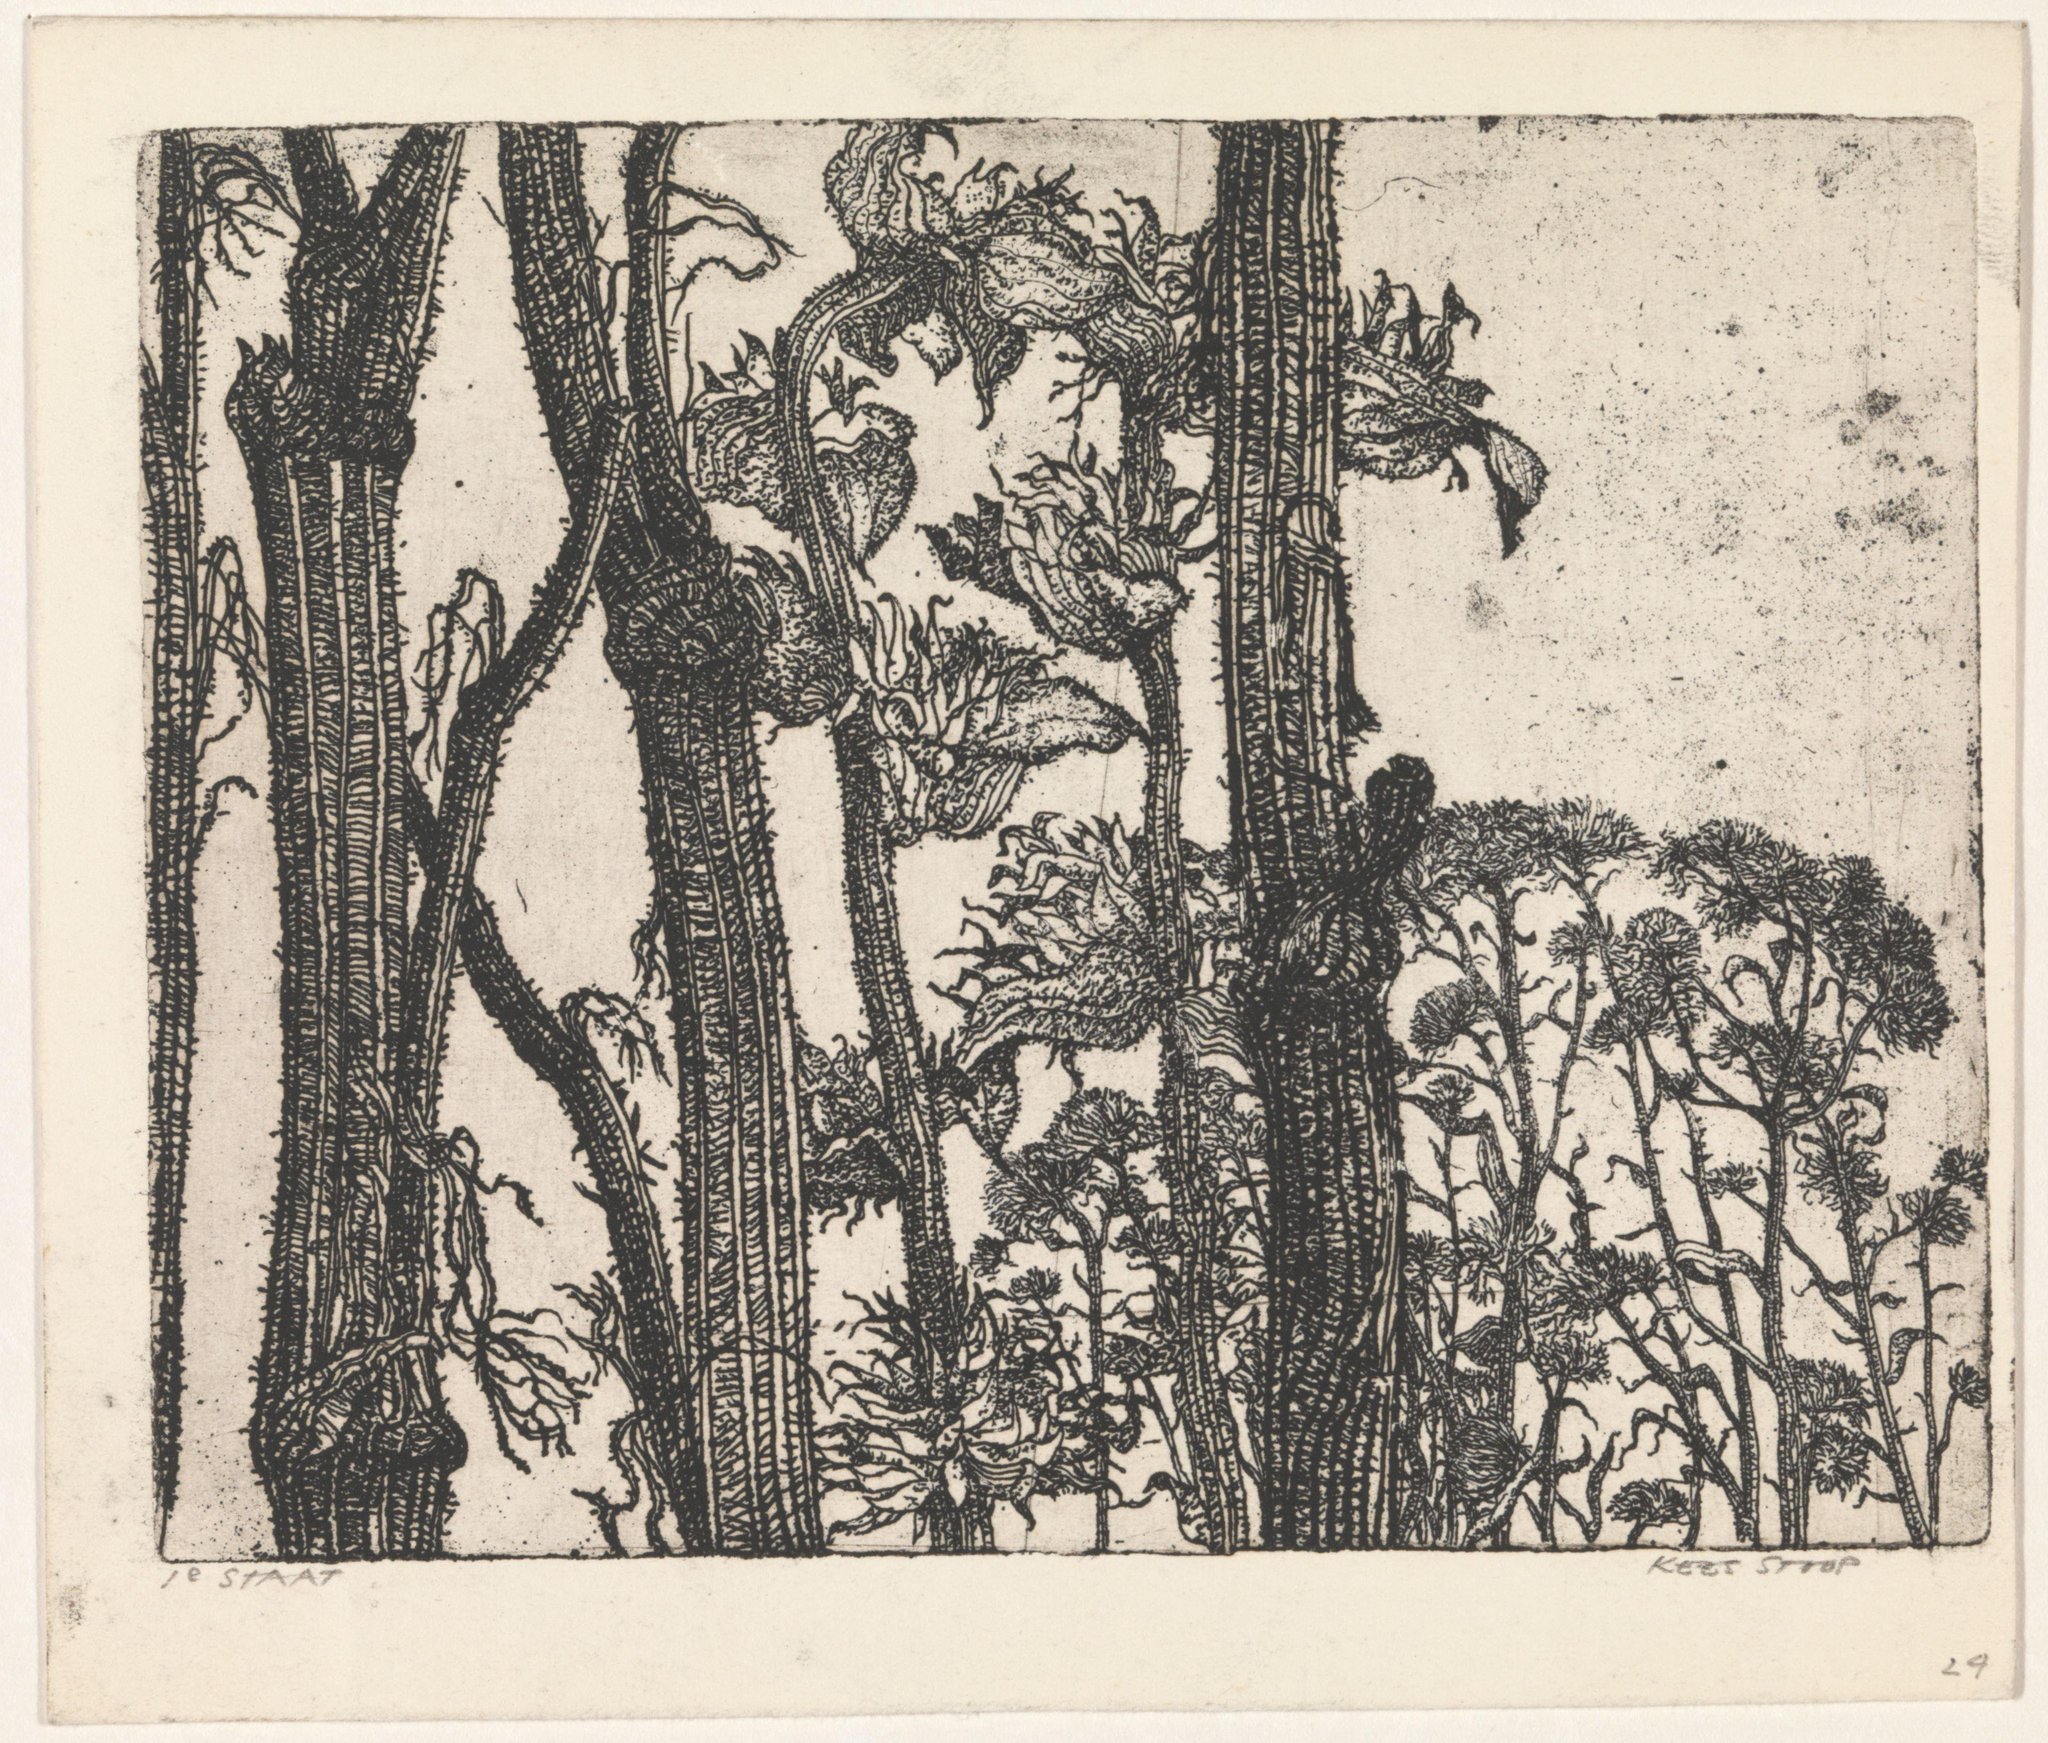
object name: print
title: Bloemstengels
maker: kees stoop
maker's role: draughtsman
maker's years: 1929-2019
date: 1970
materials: paper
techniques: etching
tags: flowers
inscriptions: signature: ‘KEES STOOP’, inscription: ‘1e STAAT’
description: Bloemstengels met verticale banen op de voorgrond, bloemen op de achtergrond op recto, afgesneden voorstelling op verso.